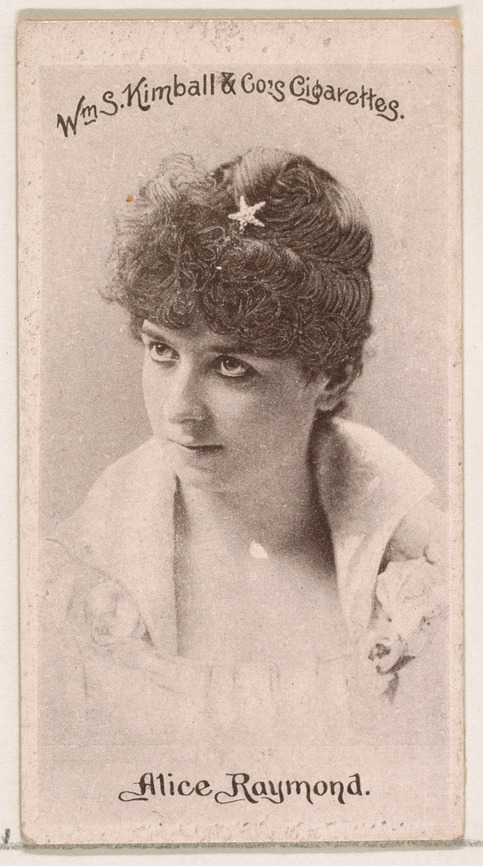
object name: print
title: Alice Raymond, from the Actresses series (N190) issued by Wm. S. Kimball & Co.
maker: william s. kimball & company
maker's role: publisher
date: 1889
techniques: lithography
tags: portraits,women,actresses